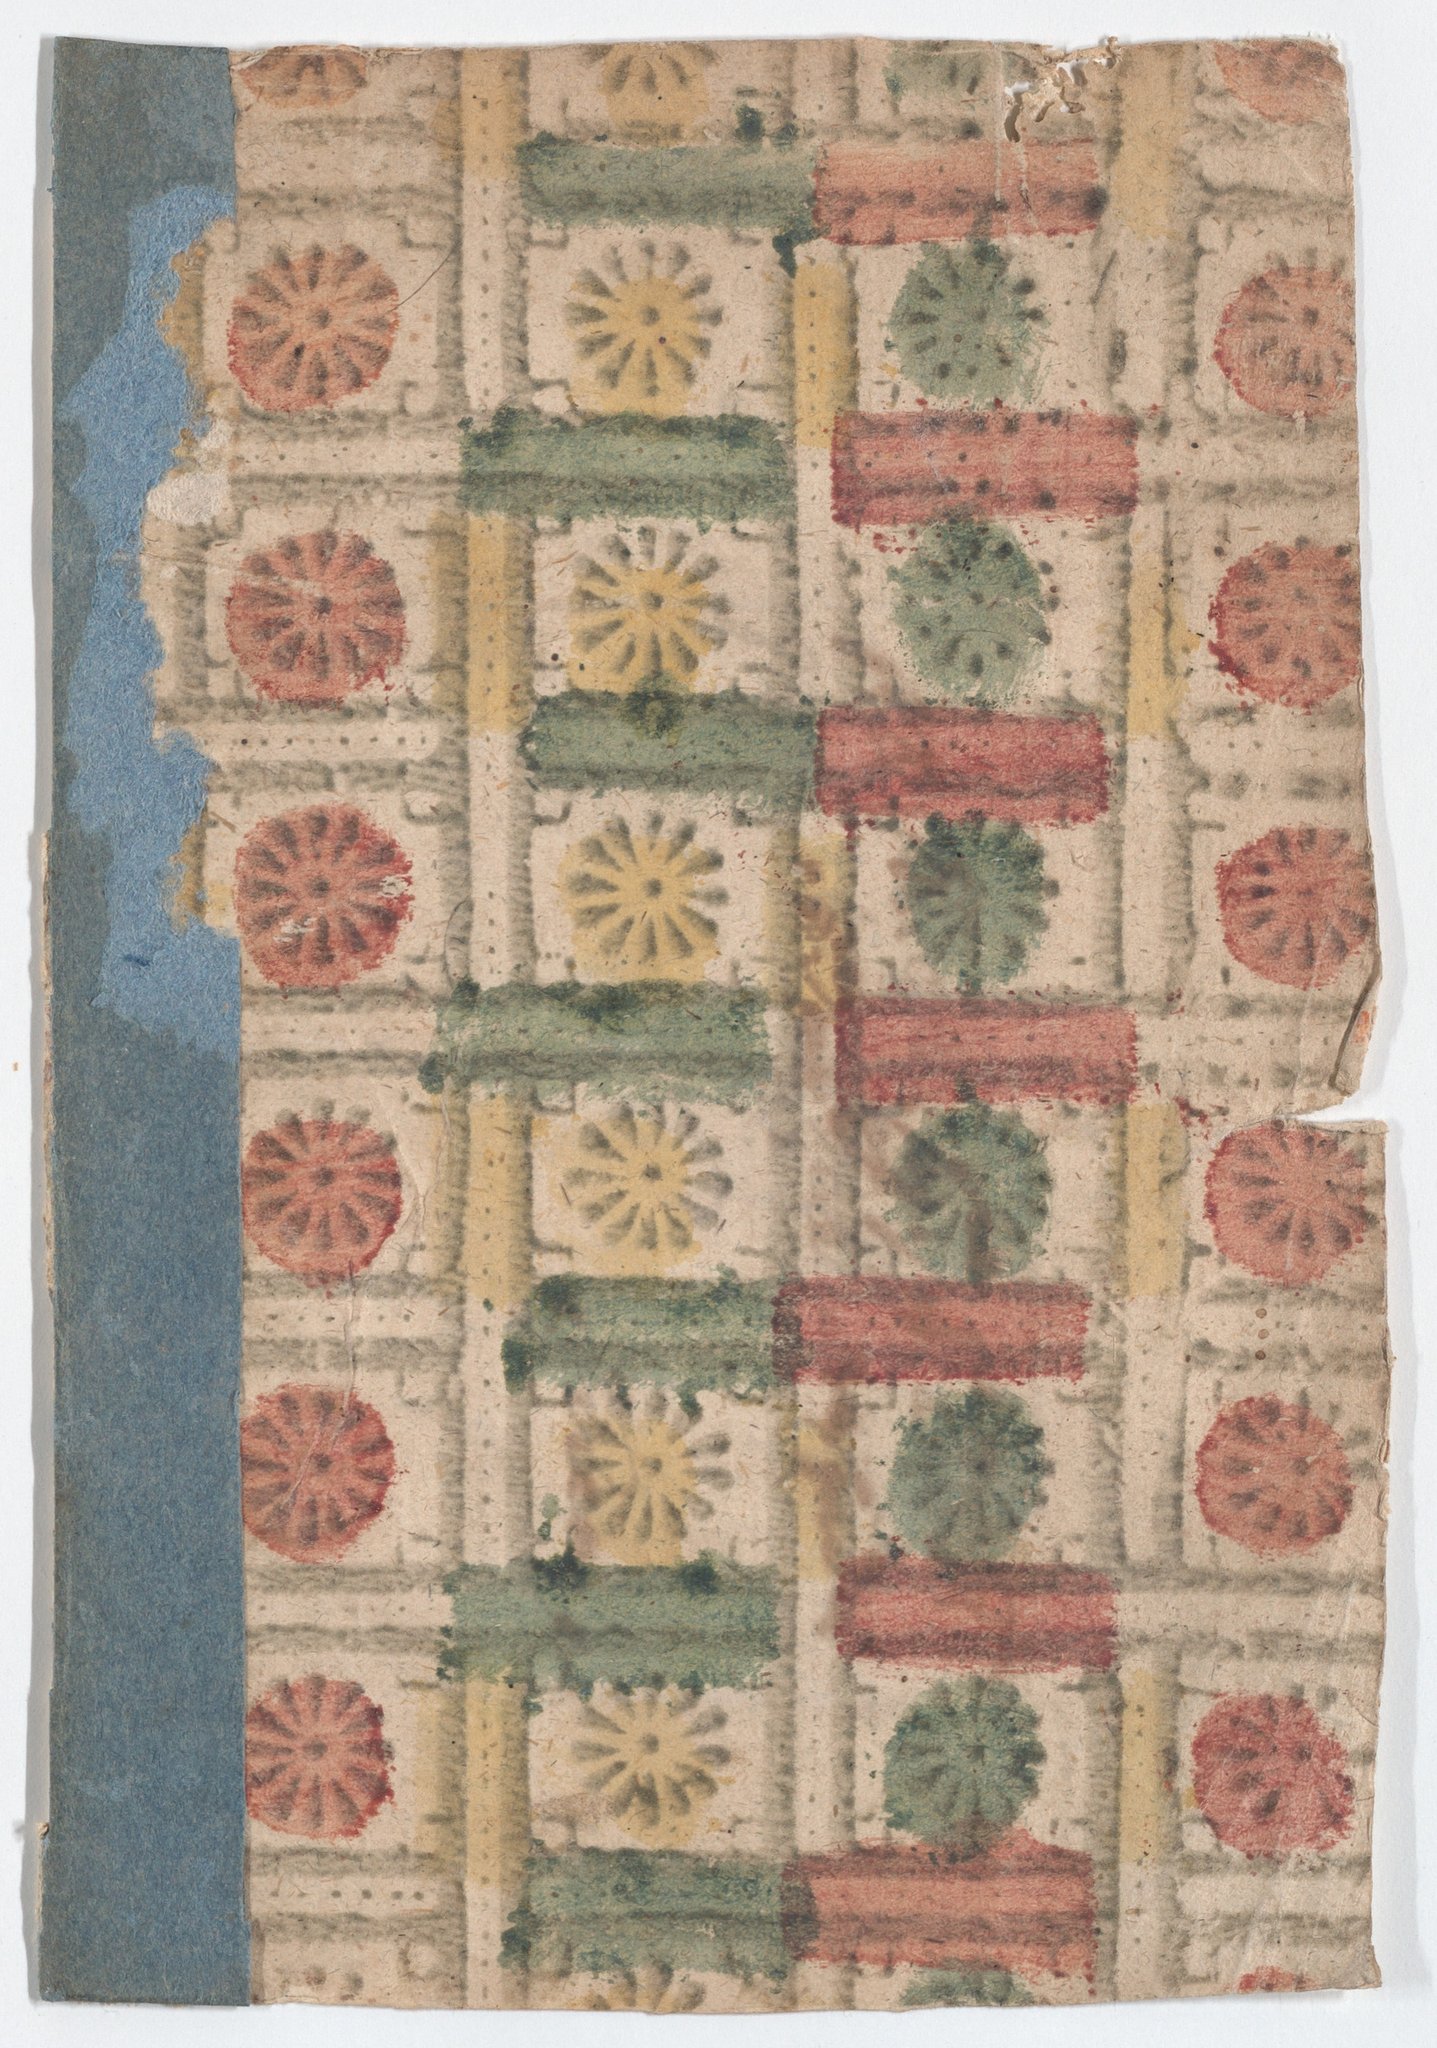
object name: print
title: Sheet with overall pattern of rosettes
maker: Anonymous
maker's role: artist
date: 1801-1900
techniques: relief print